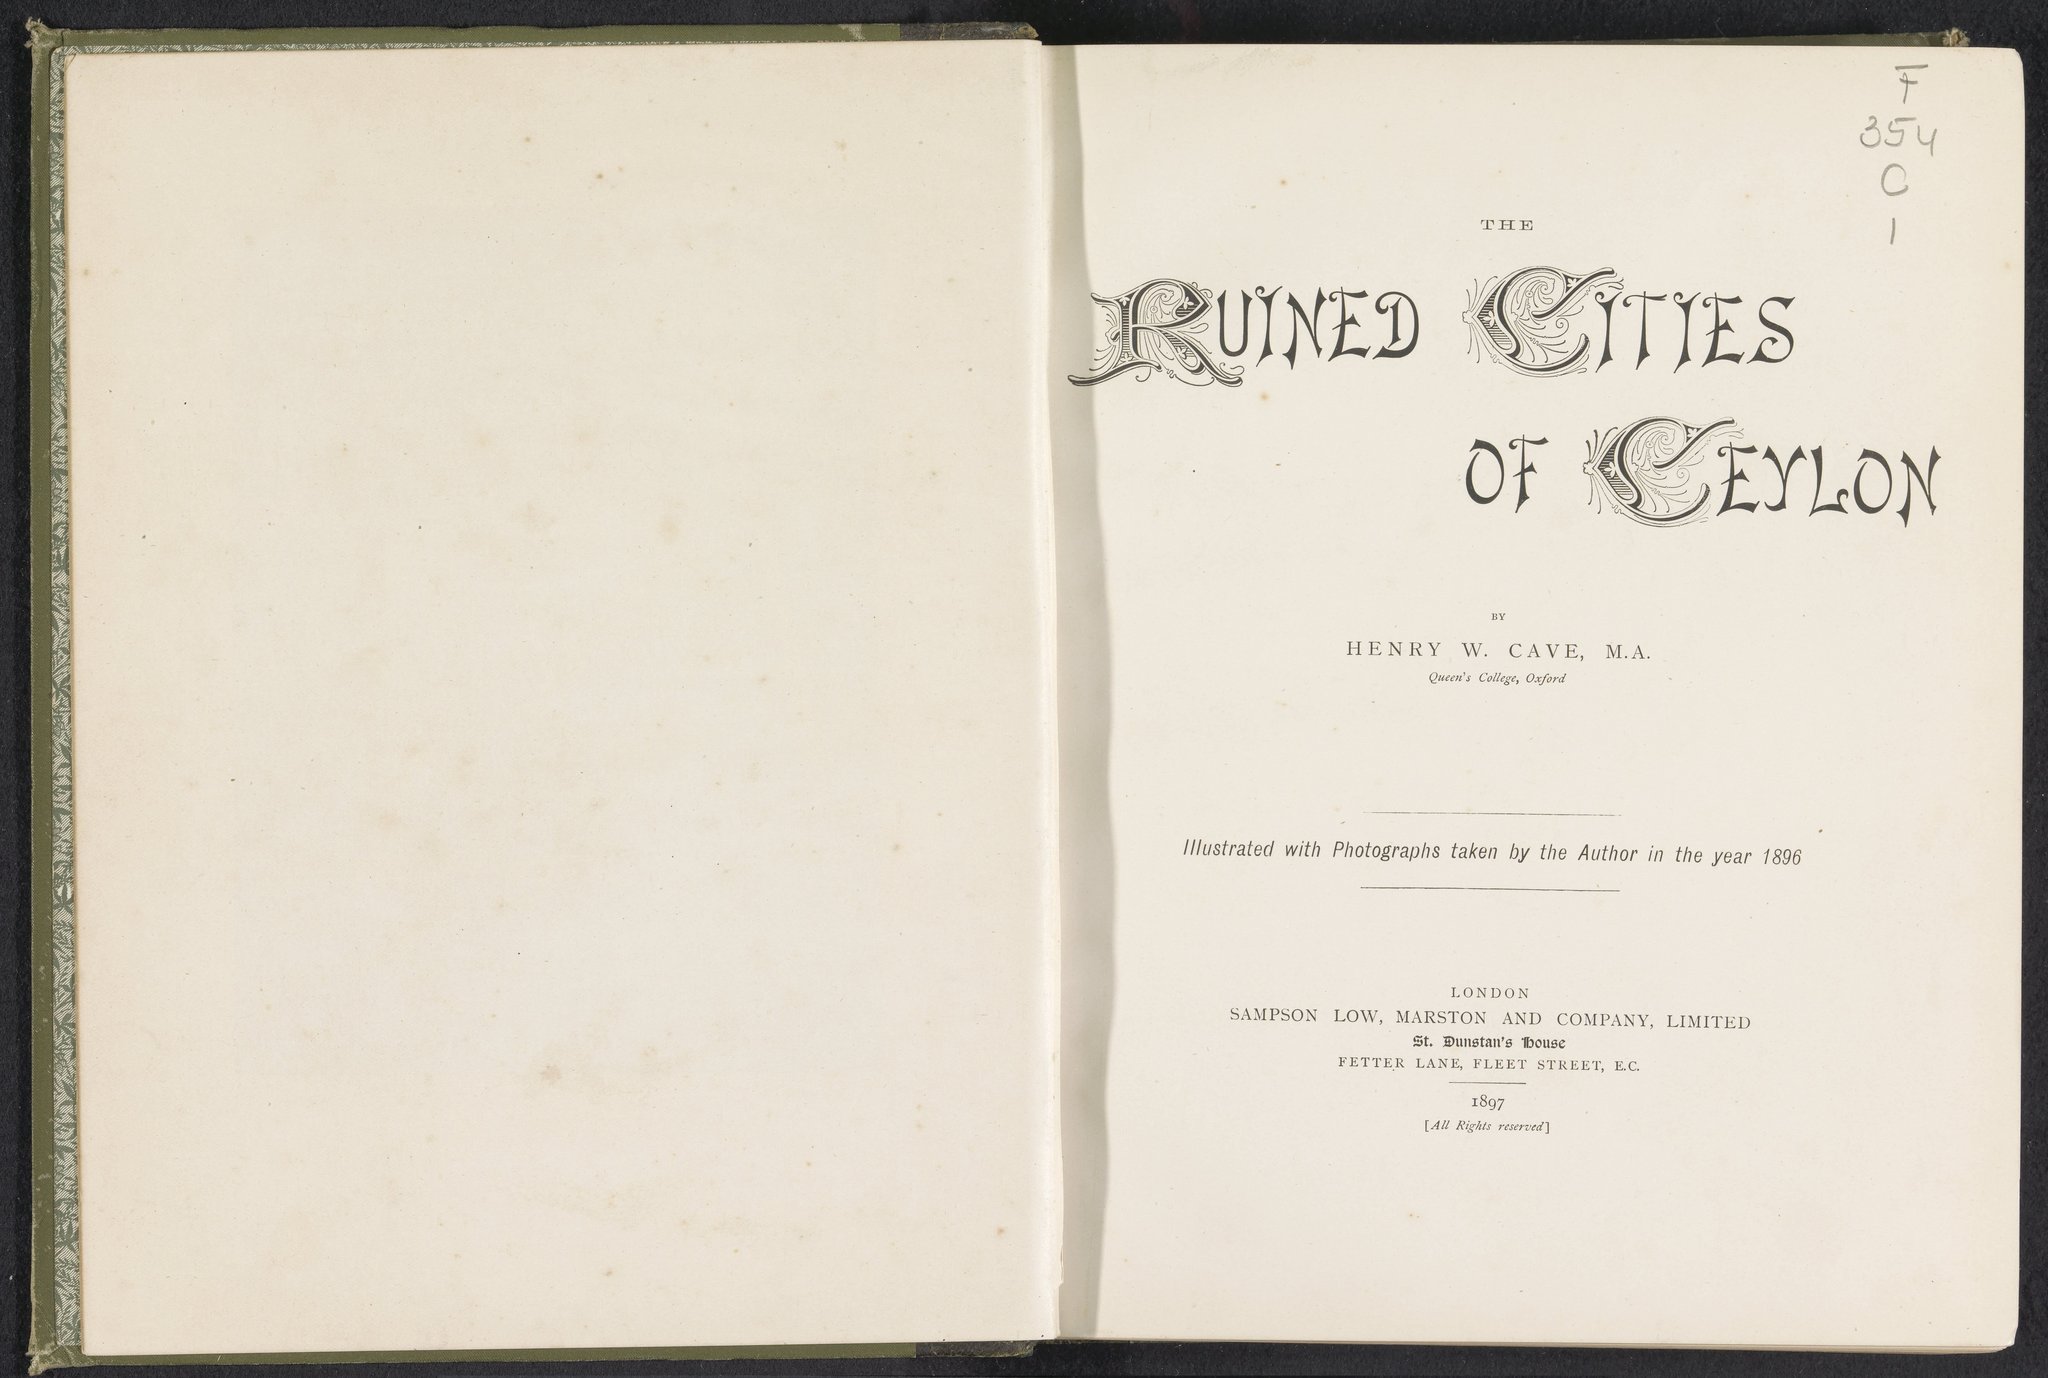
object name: book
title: The ruined cities of Ceylon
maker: henry william cave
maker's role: fotograaf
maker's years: 1854-1913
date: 1897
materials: cardboard, linen, paper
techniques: printing, woodburygravure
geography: london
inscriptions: name: ‘J. Hanley Power’